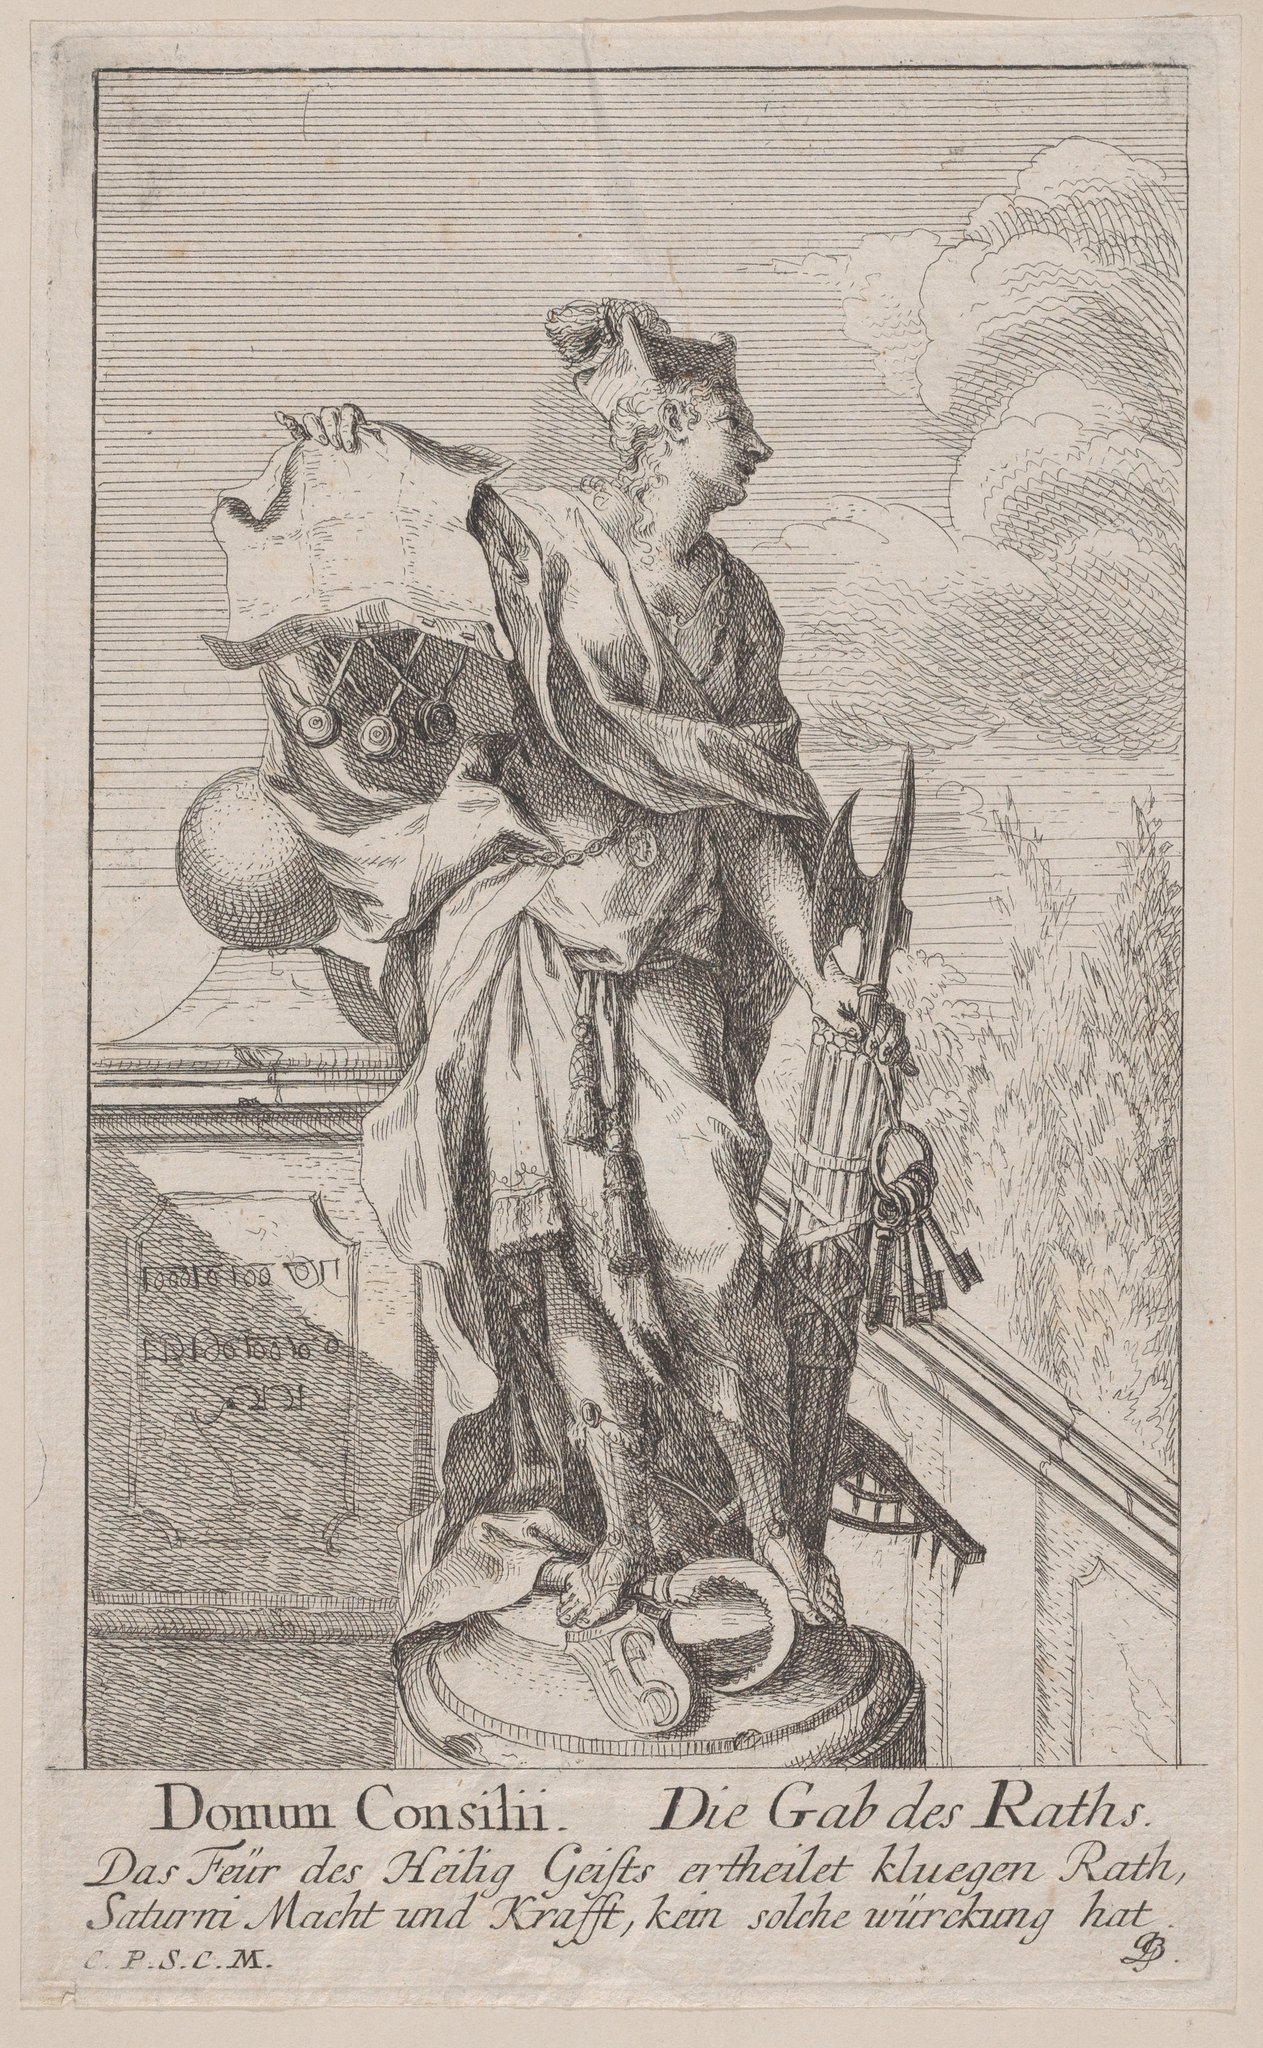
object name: print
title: The Gift of Counsel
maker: johann georg bergmüller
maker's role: artist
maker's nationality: german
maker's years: 1688-1762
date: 1710-1762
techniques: etching